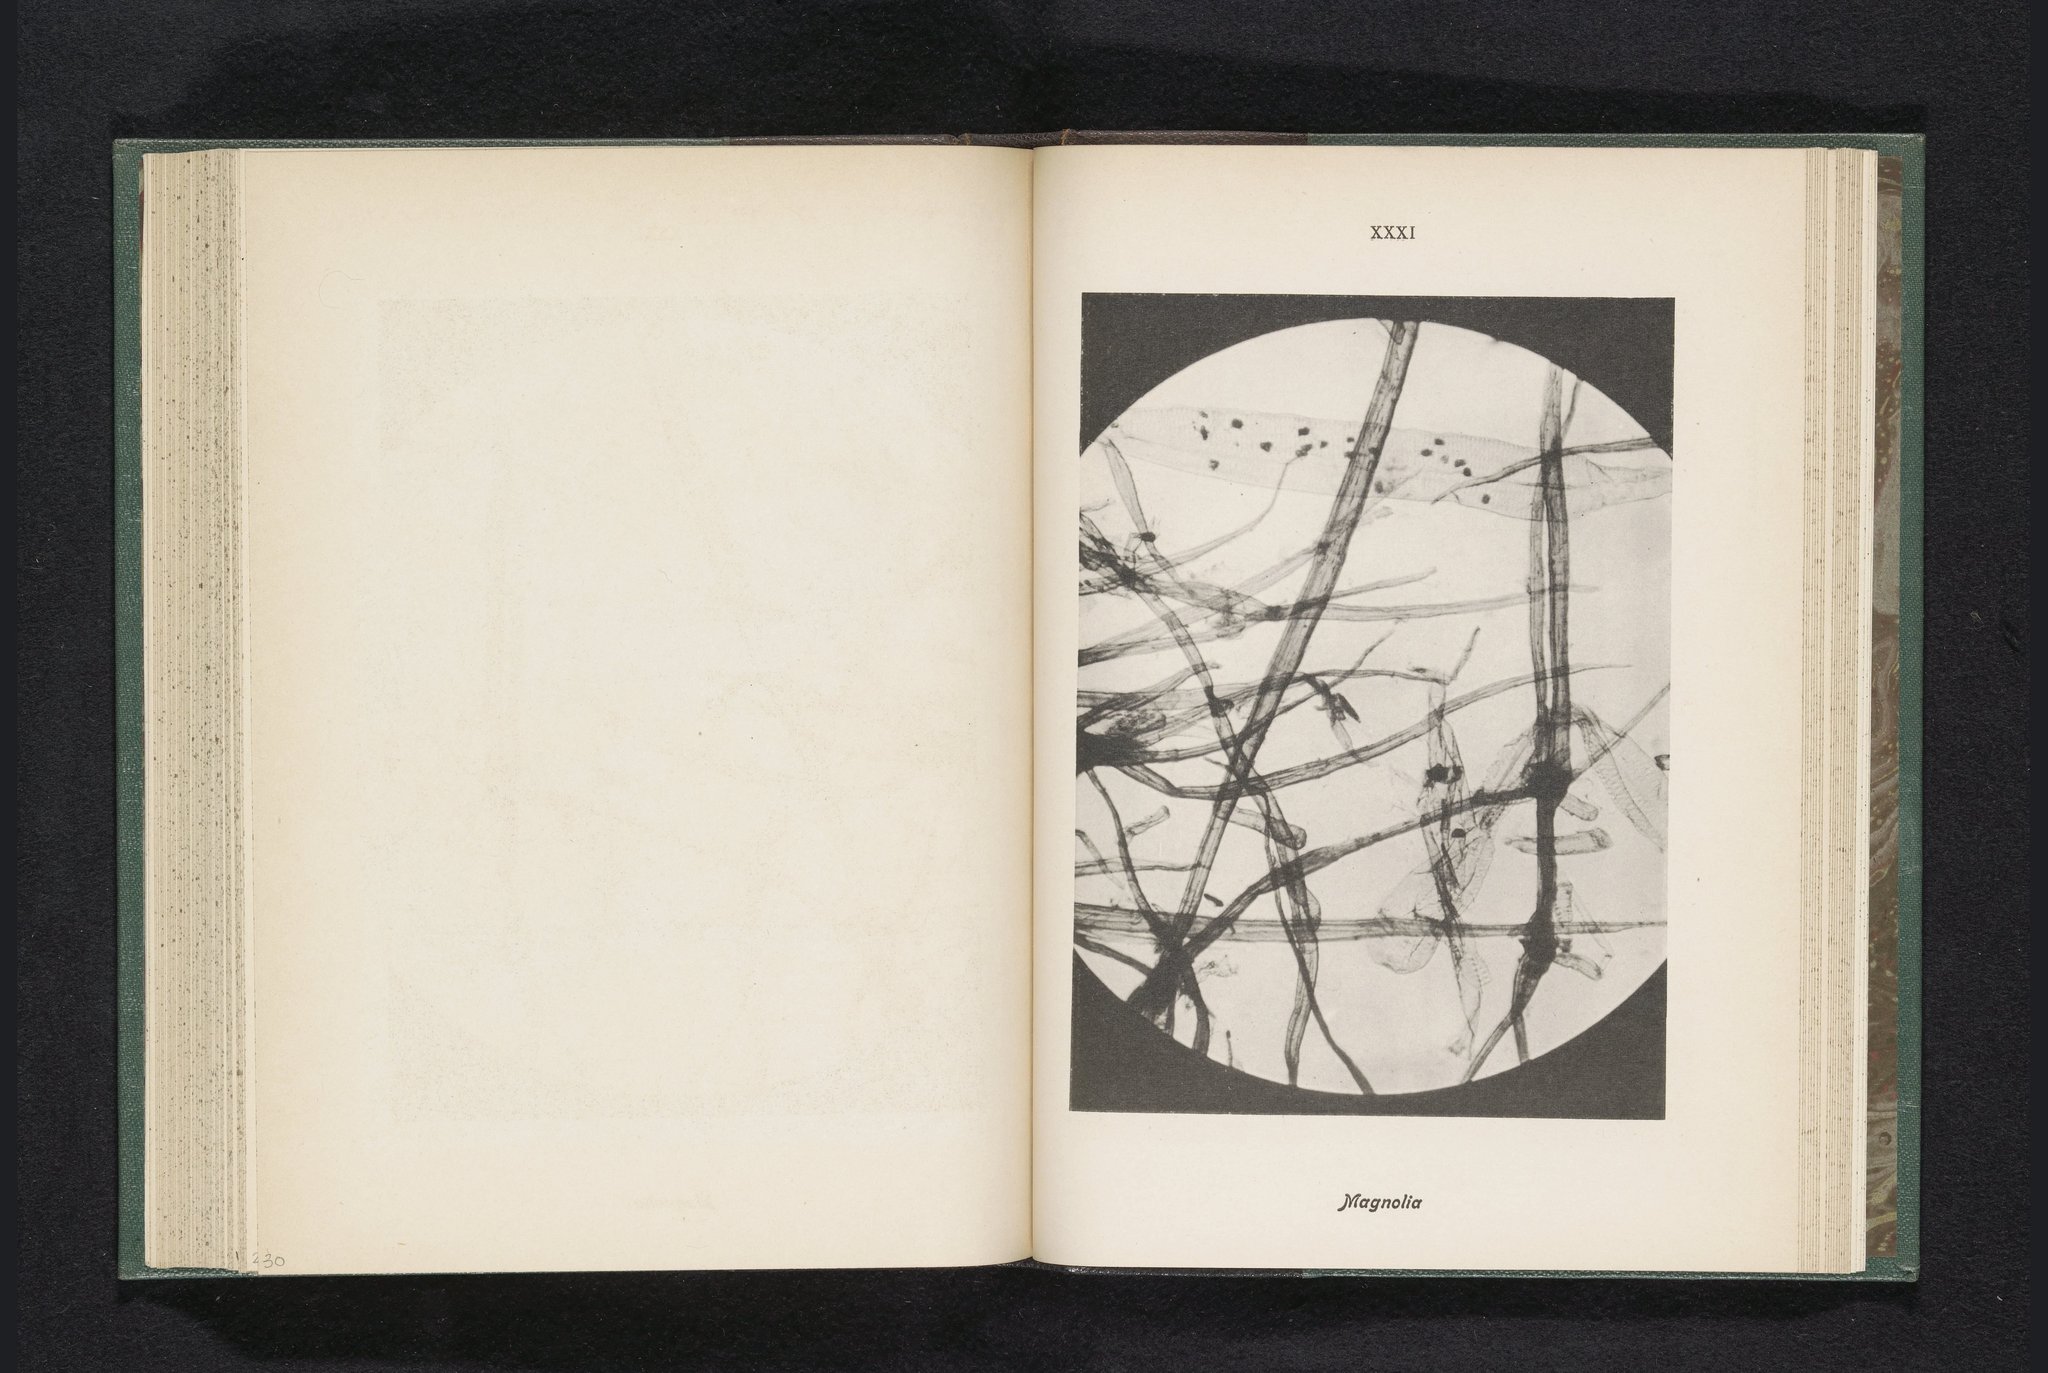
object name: page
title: Magnolia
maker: Anonymous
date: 1890-1900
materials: paper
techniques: photograph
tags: trees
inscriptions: number: ‘XXXI’